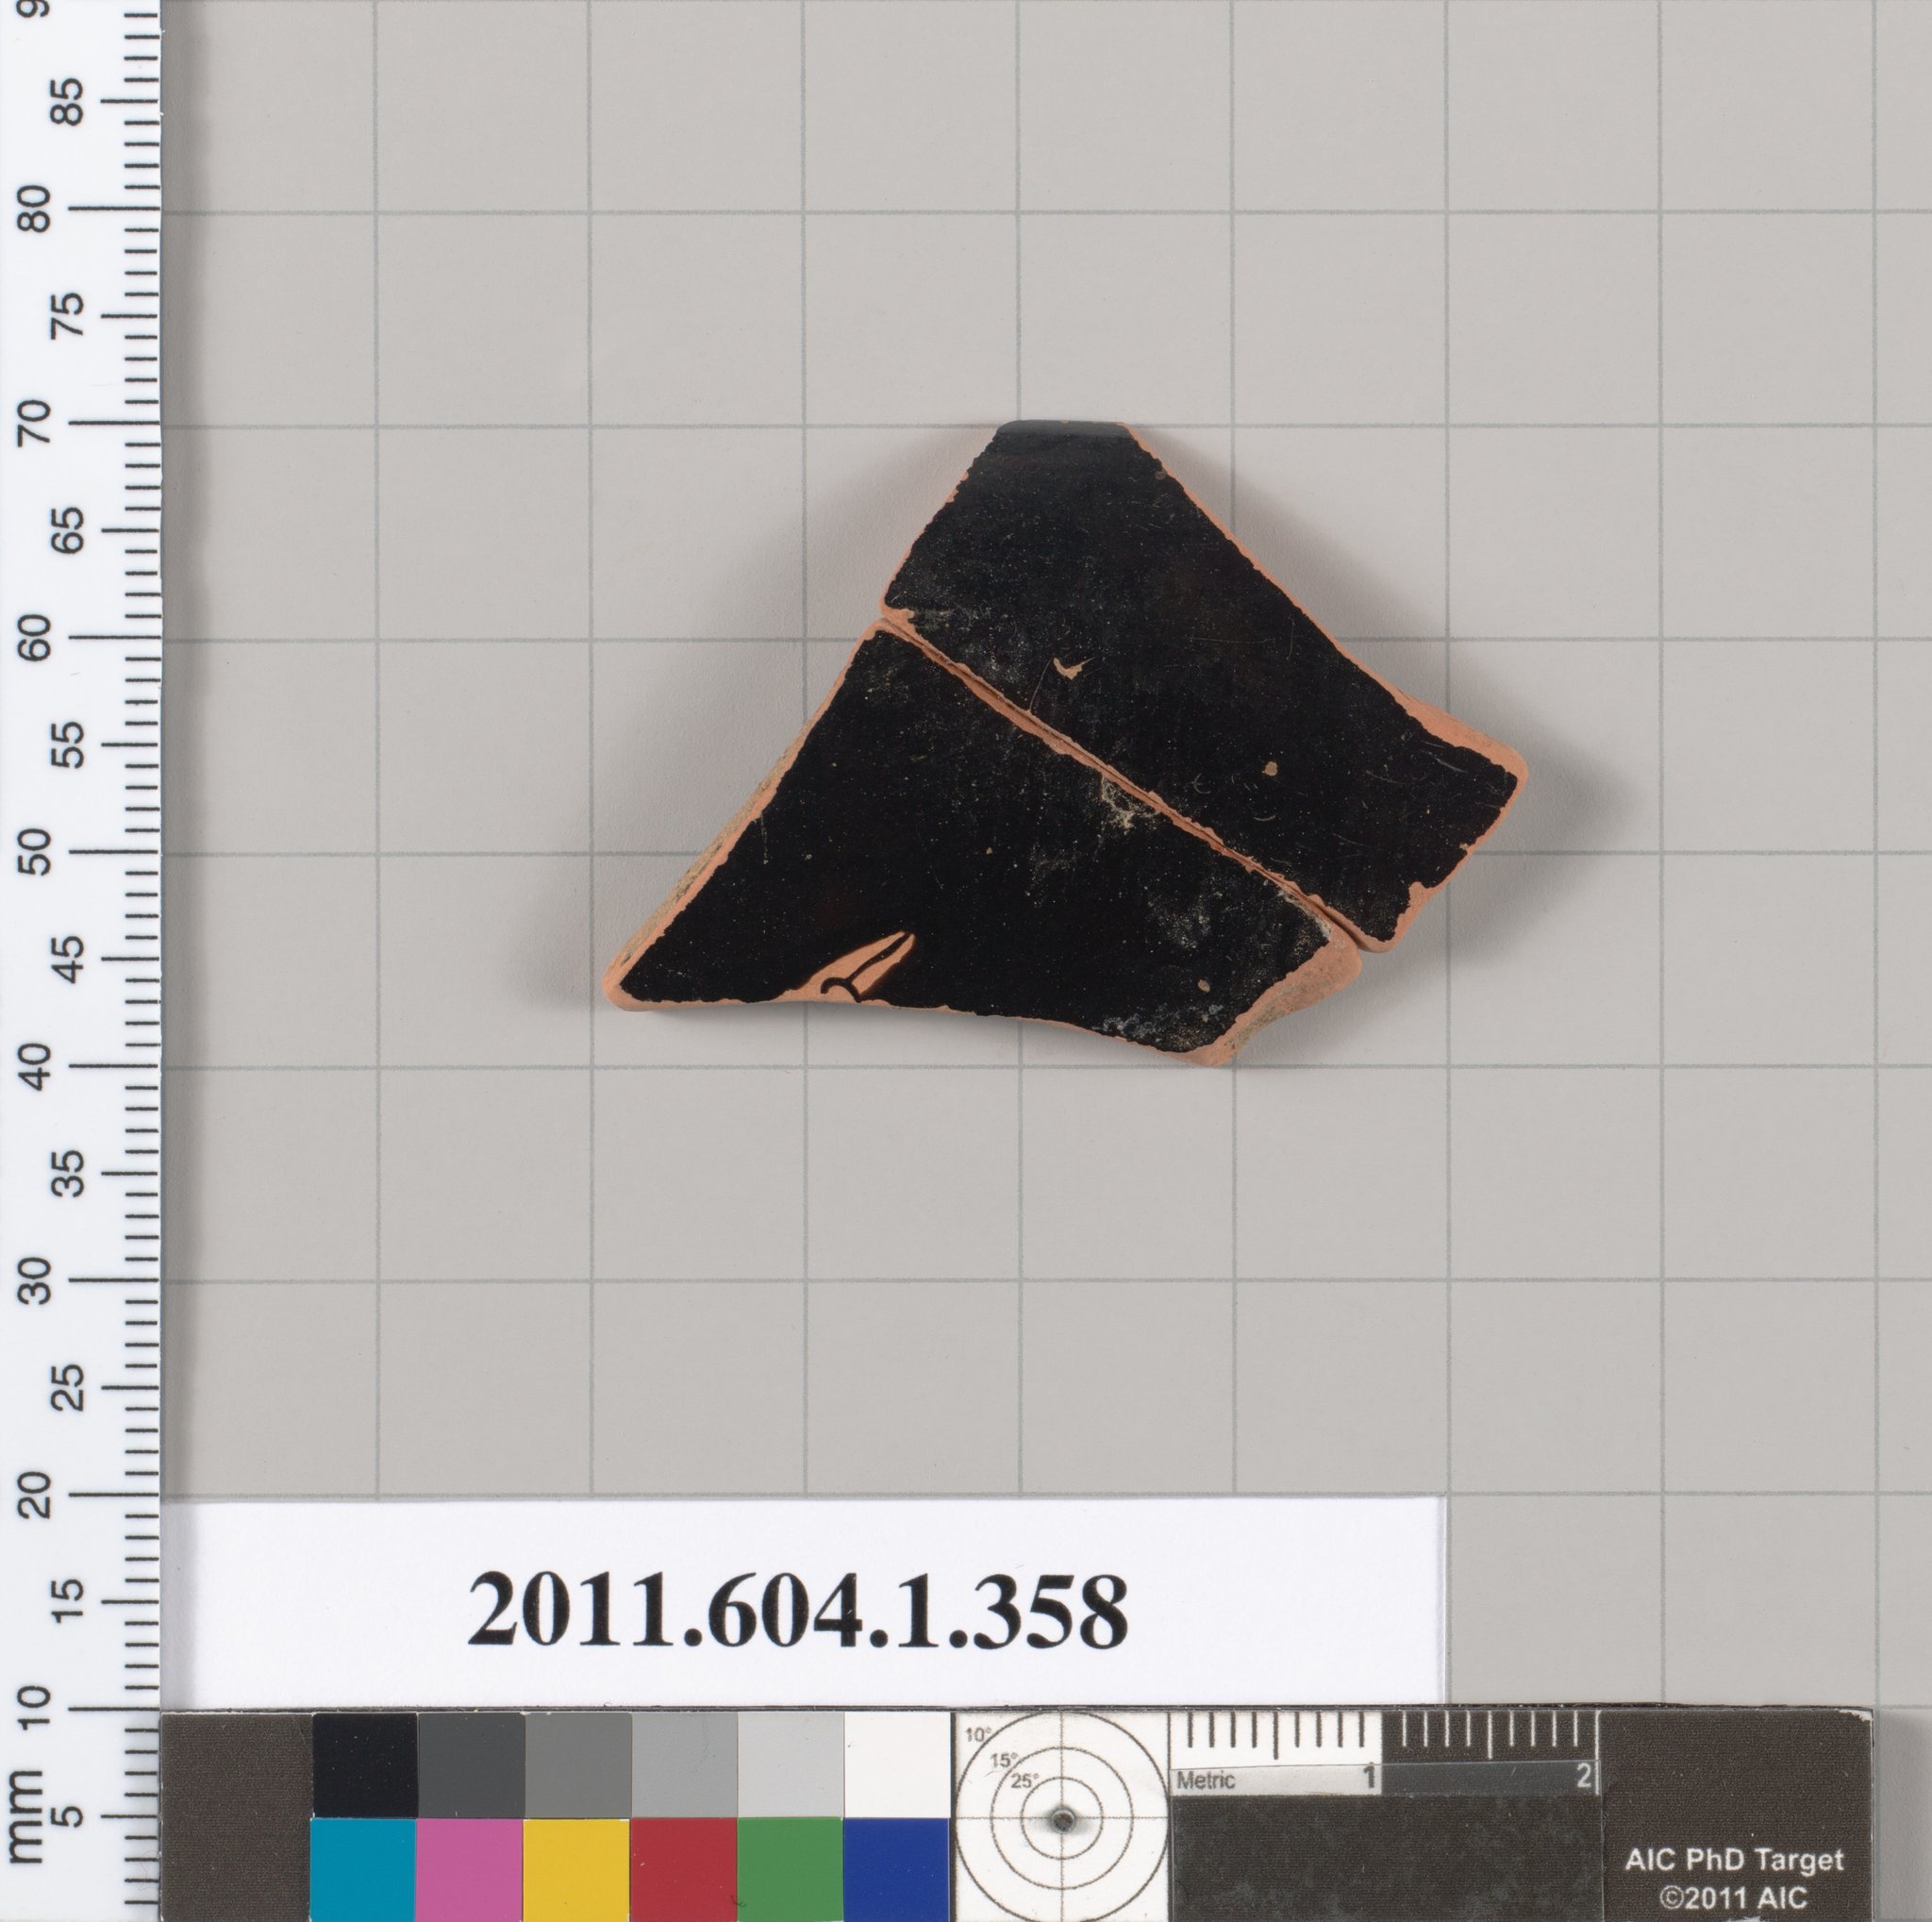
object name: kylix fragment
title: Terracotta rim fragment of a kylix (drinking cup)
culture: greek, attic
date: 475-451 BCE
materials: terracotta